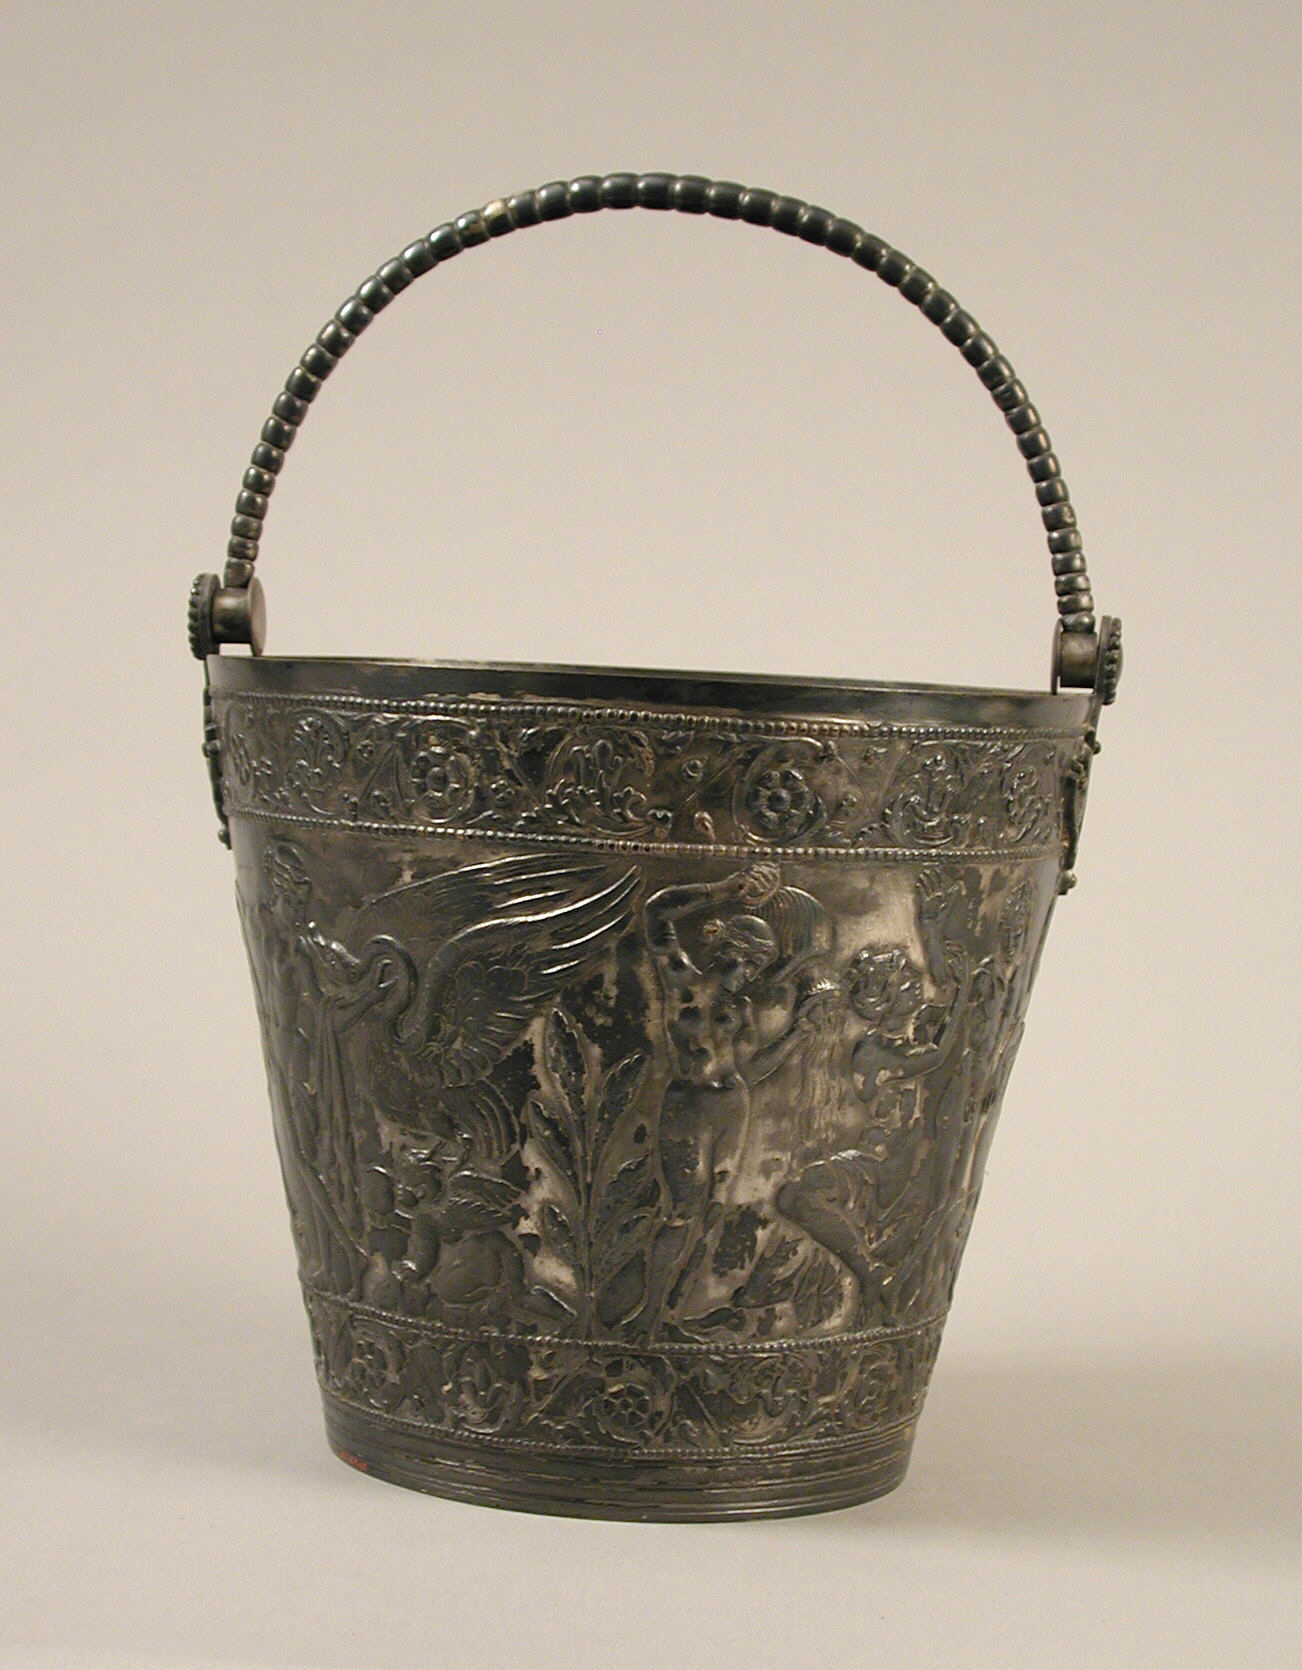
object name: situla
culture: byzantine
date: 1801-1900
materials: silver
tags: birds,women